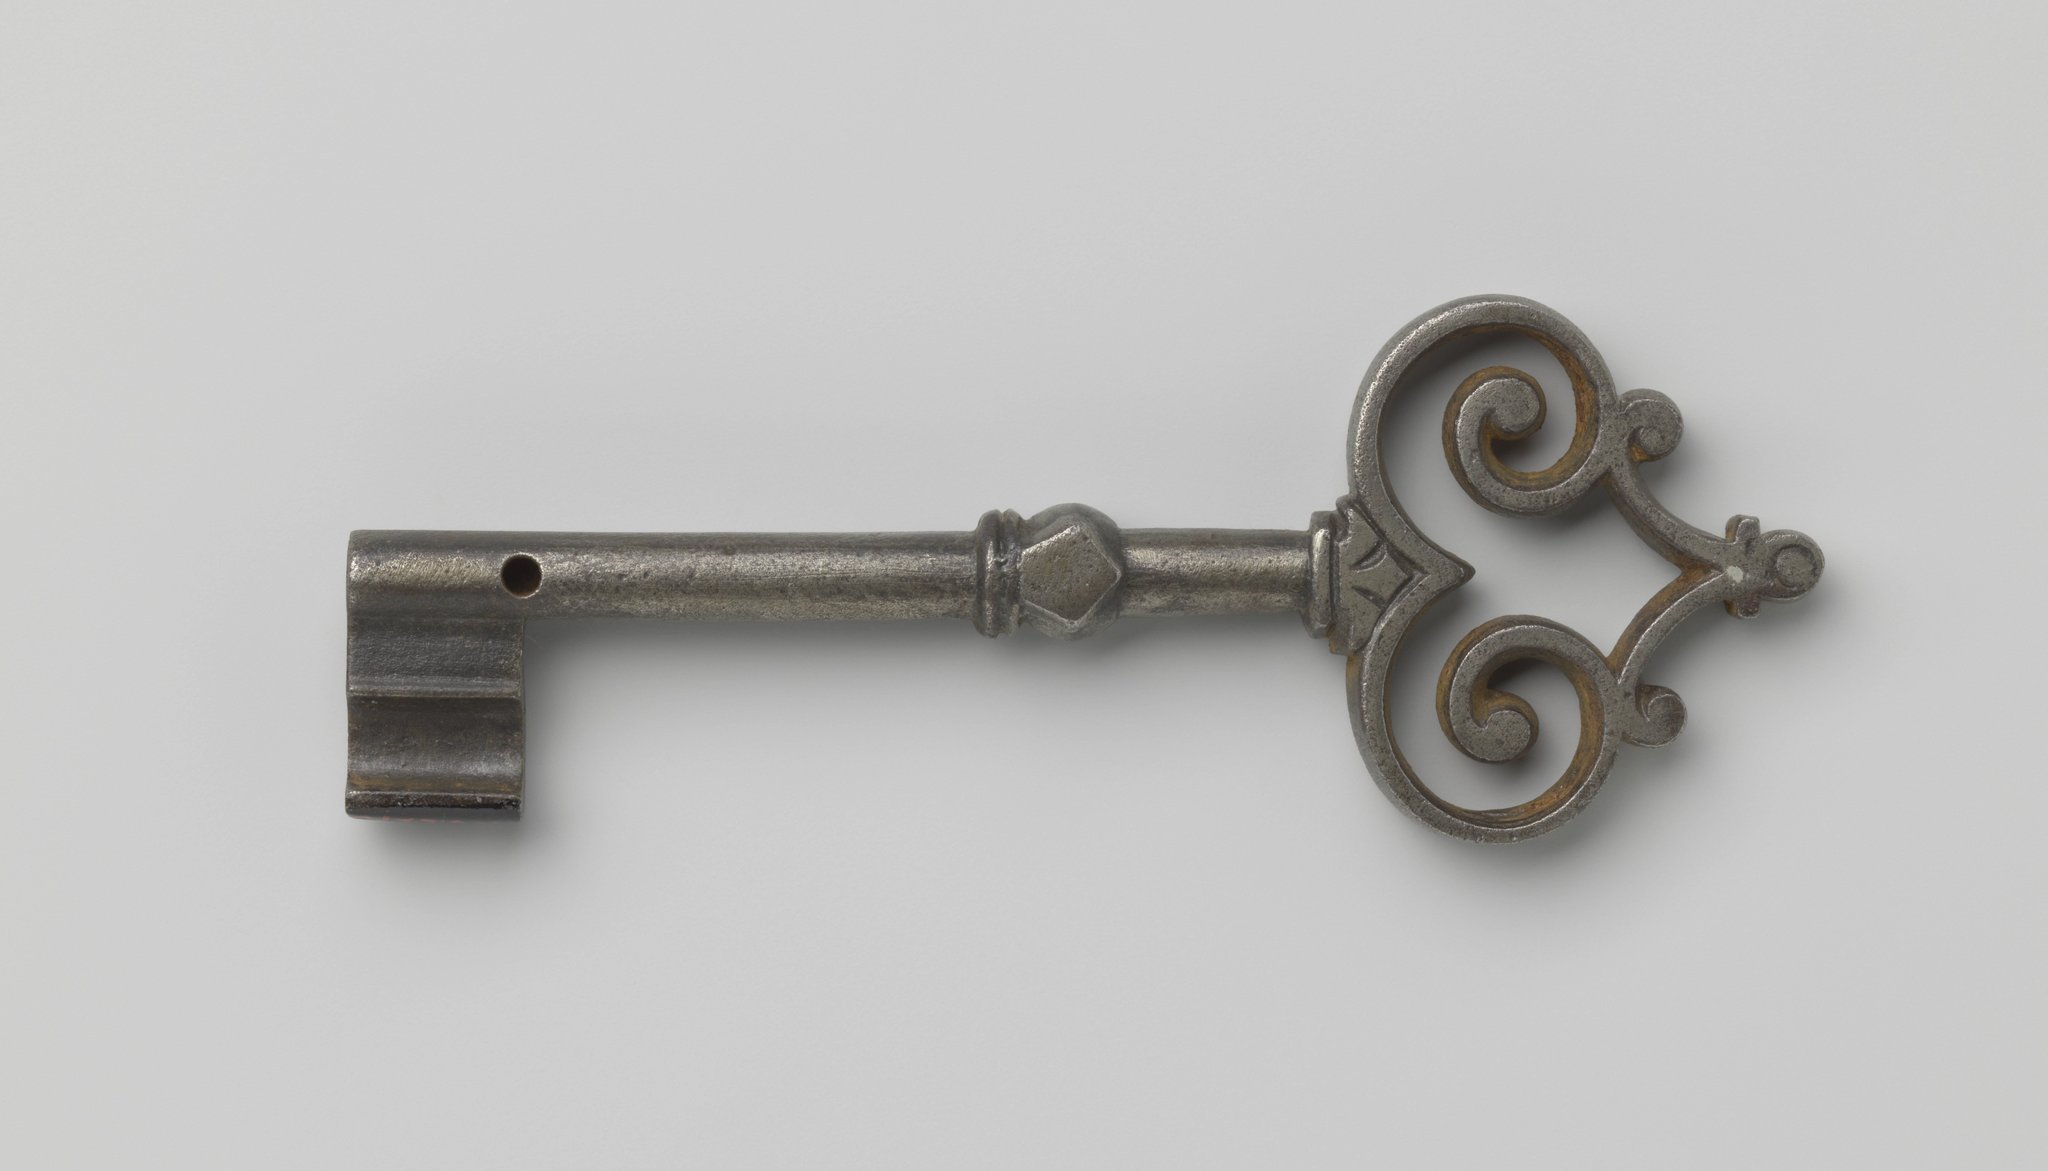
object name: key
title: Sleutel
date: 1400-1950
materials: iron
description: Sleutel waarvan de greep bestaat uit twee vanaf de steel ontspringende, naar elkaar toegewende, horizontaal liggende voluten. Zij worden boven afgedekt door een zadel.